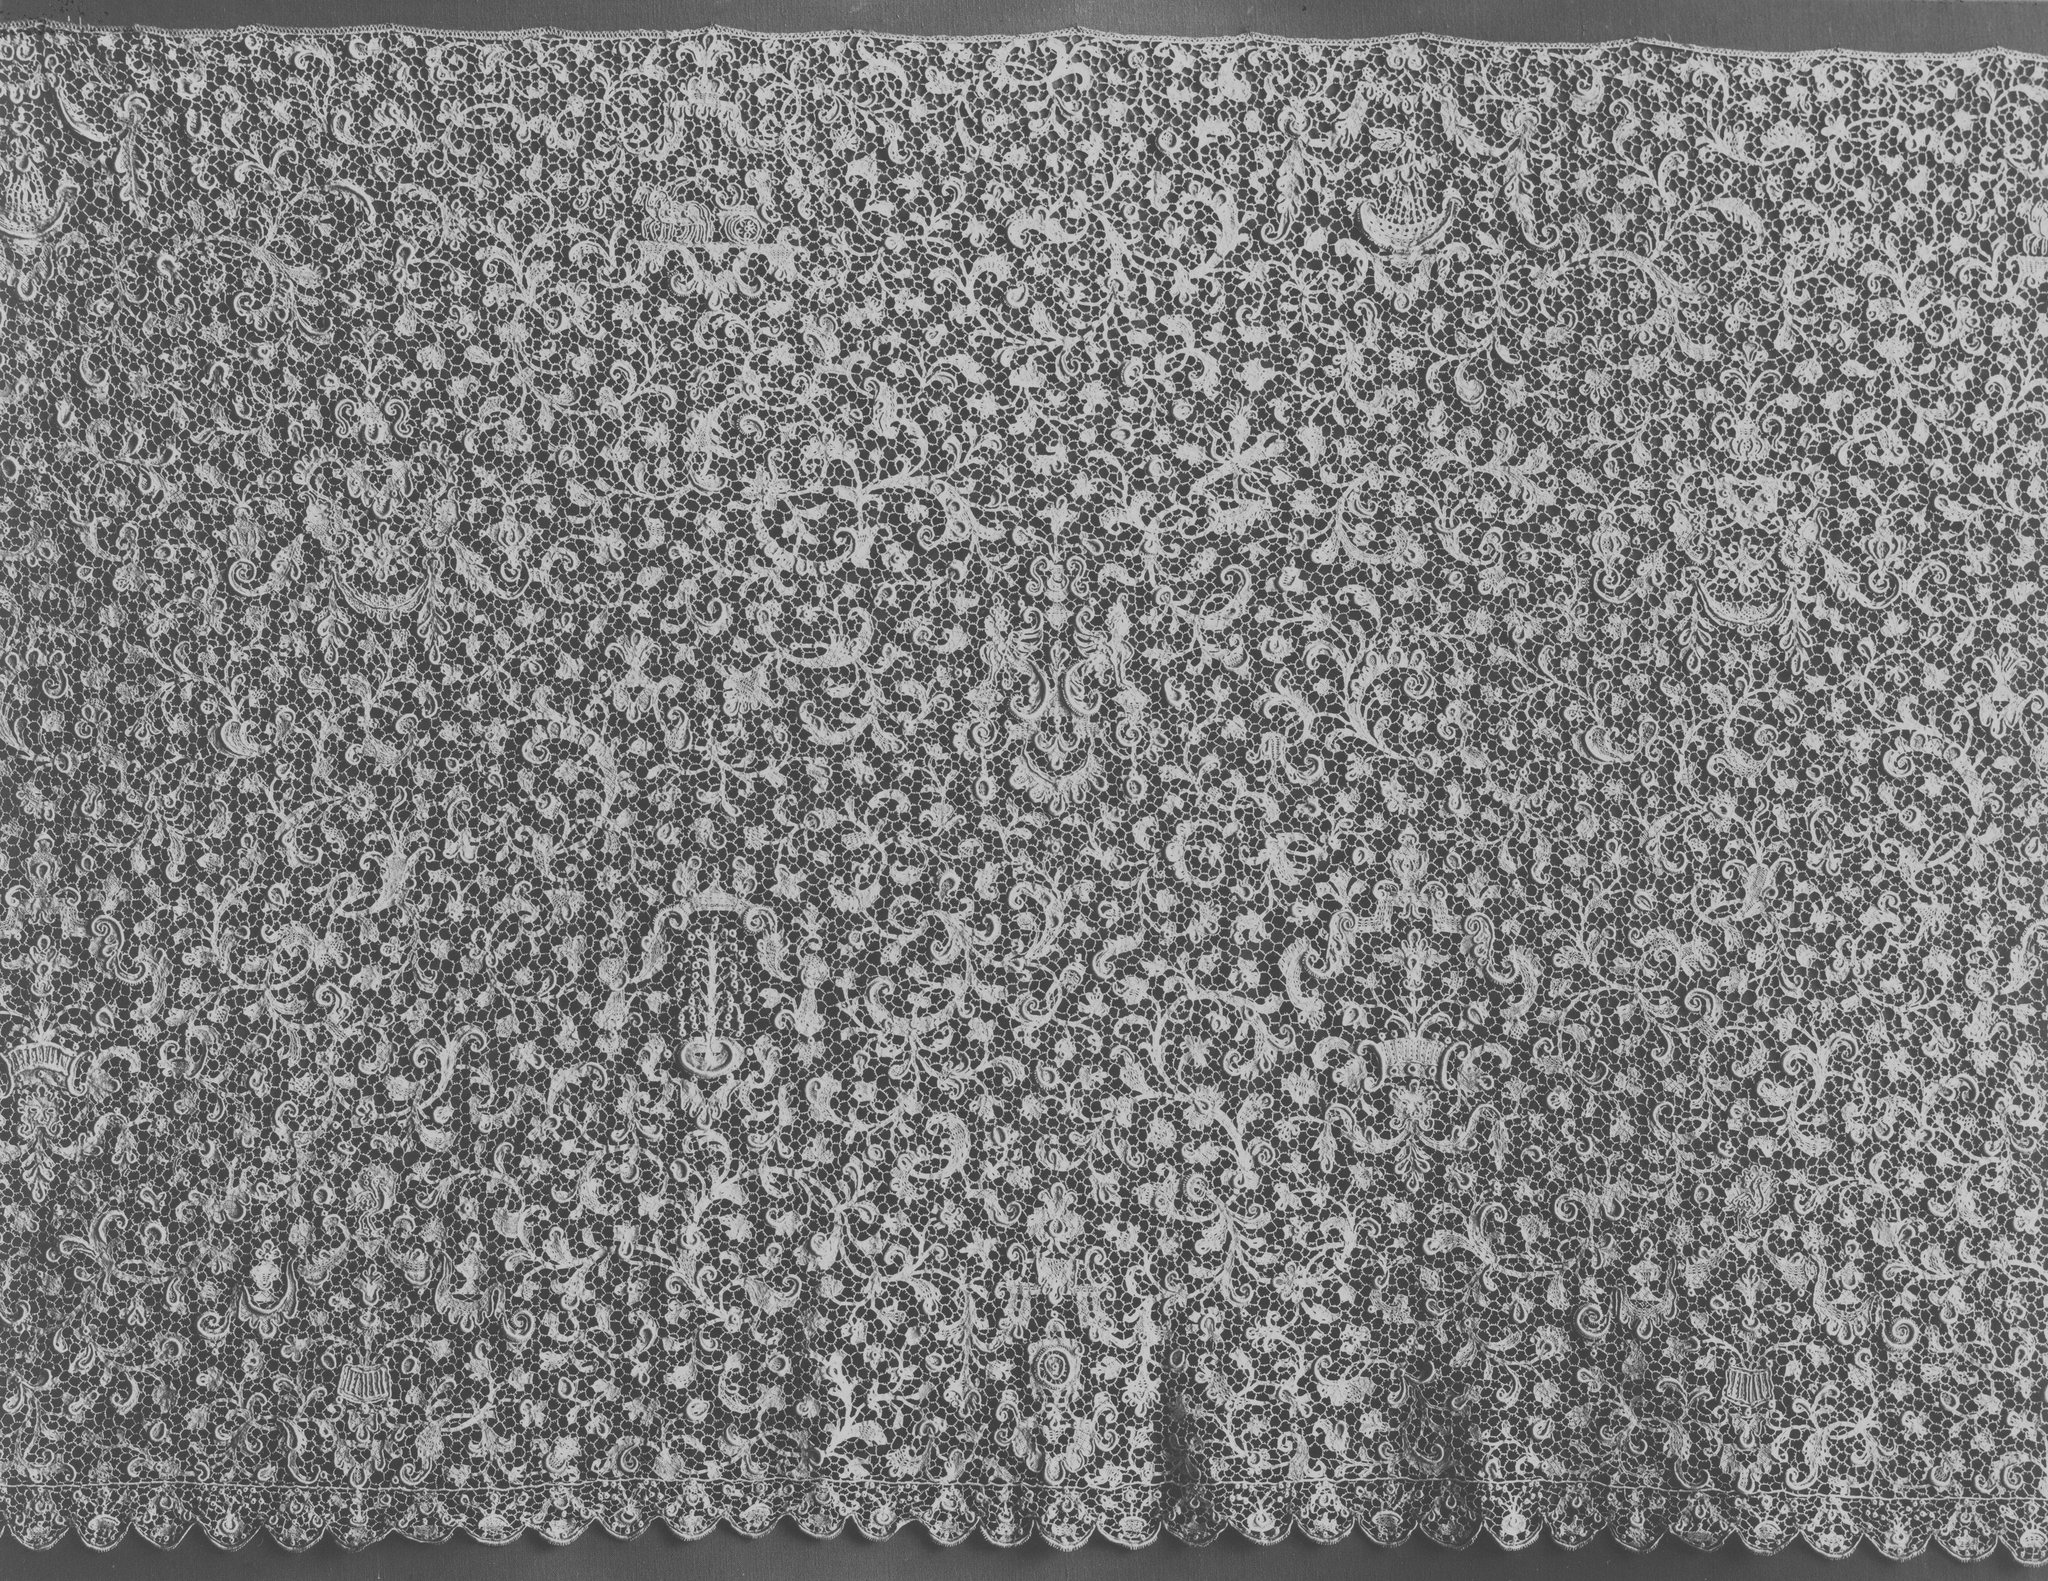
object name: flounce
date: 1801-1900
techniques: lace